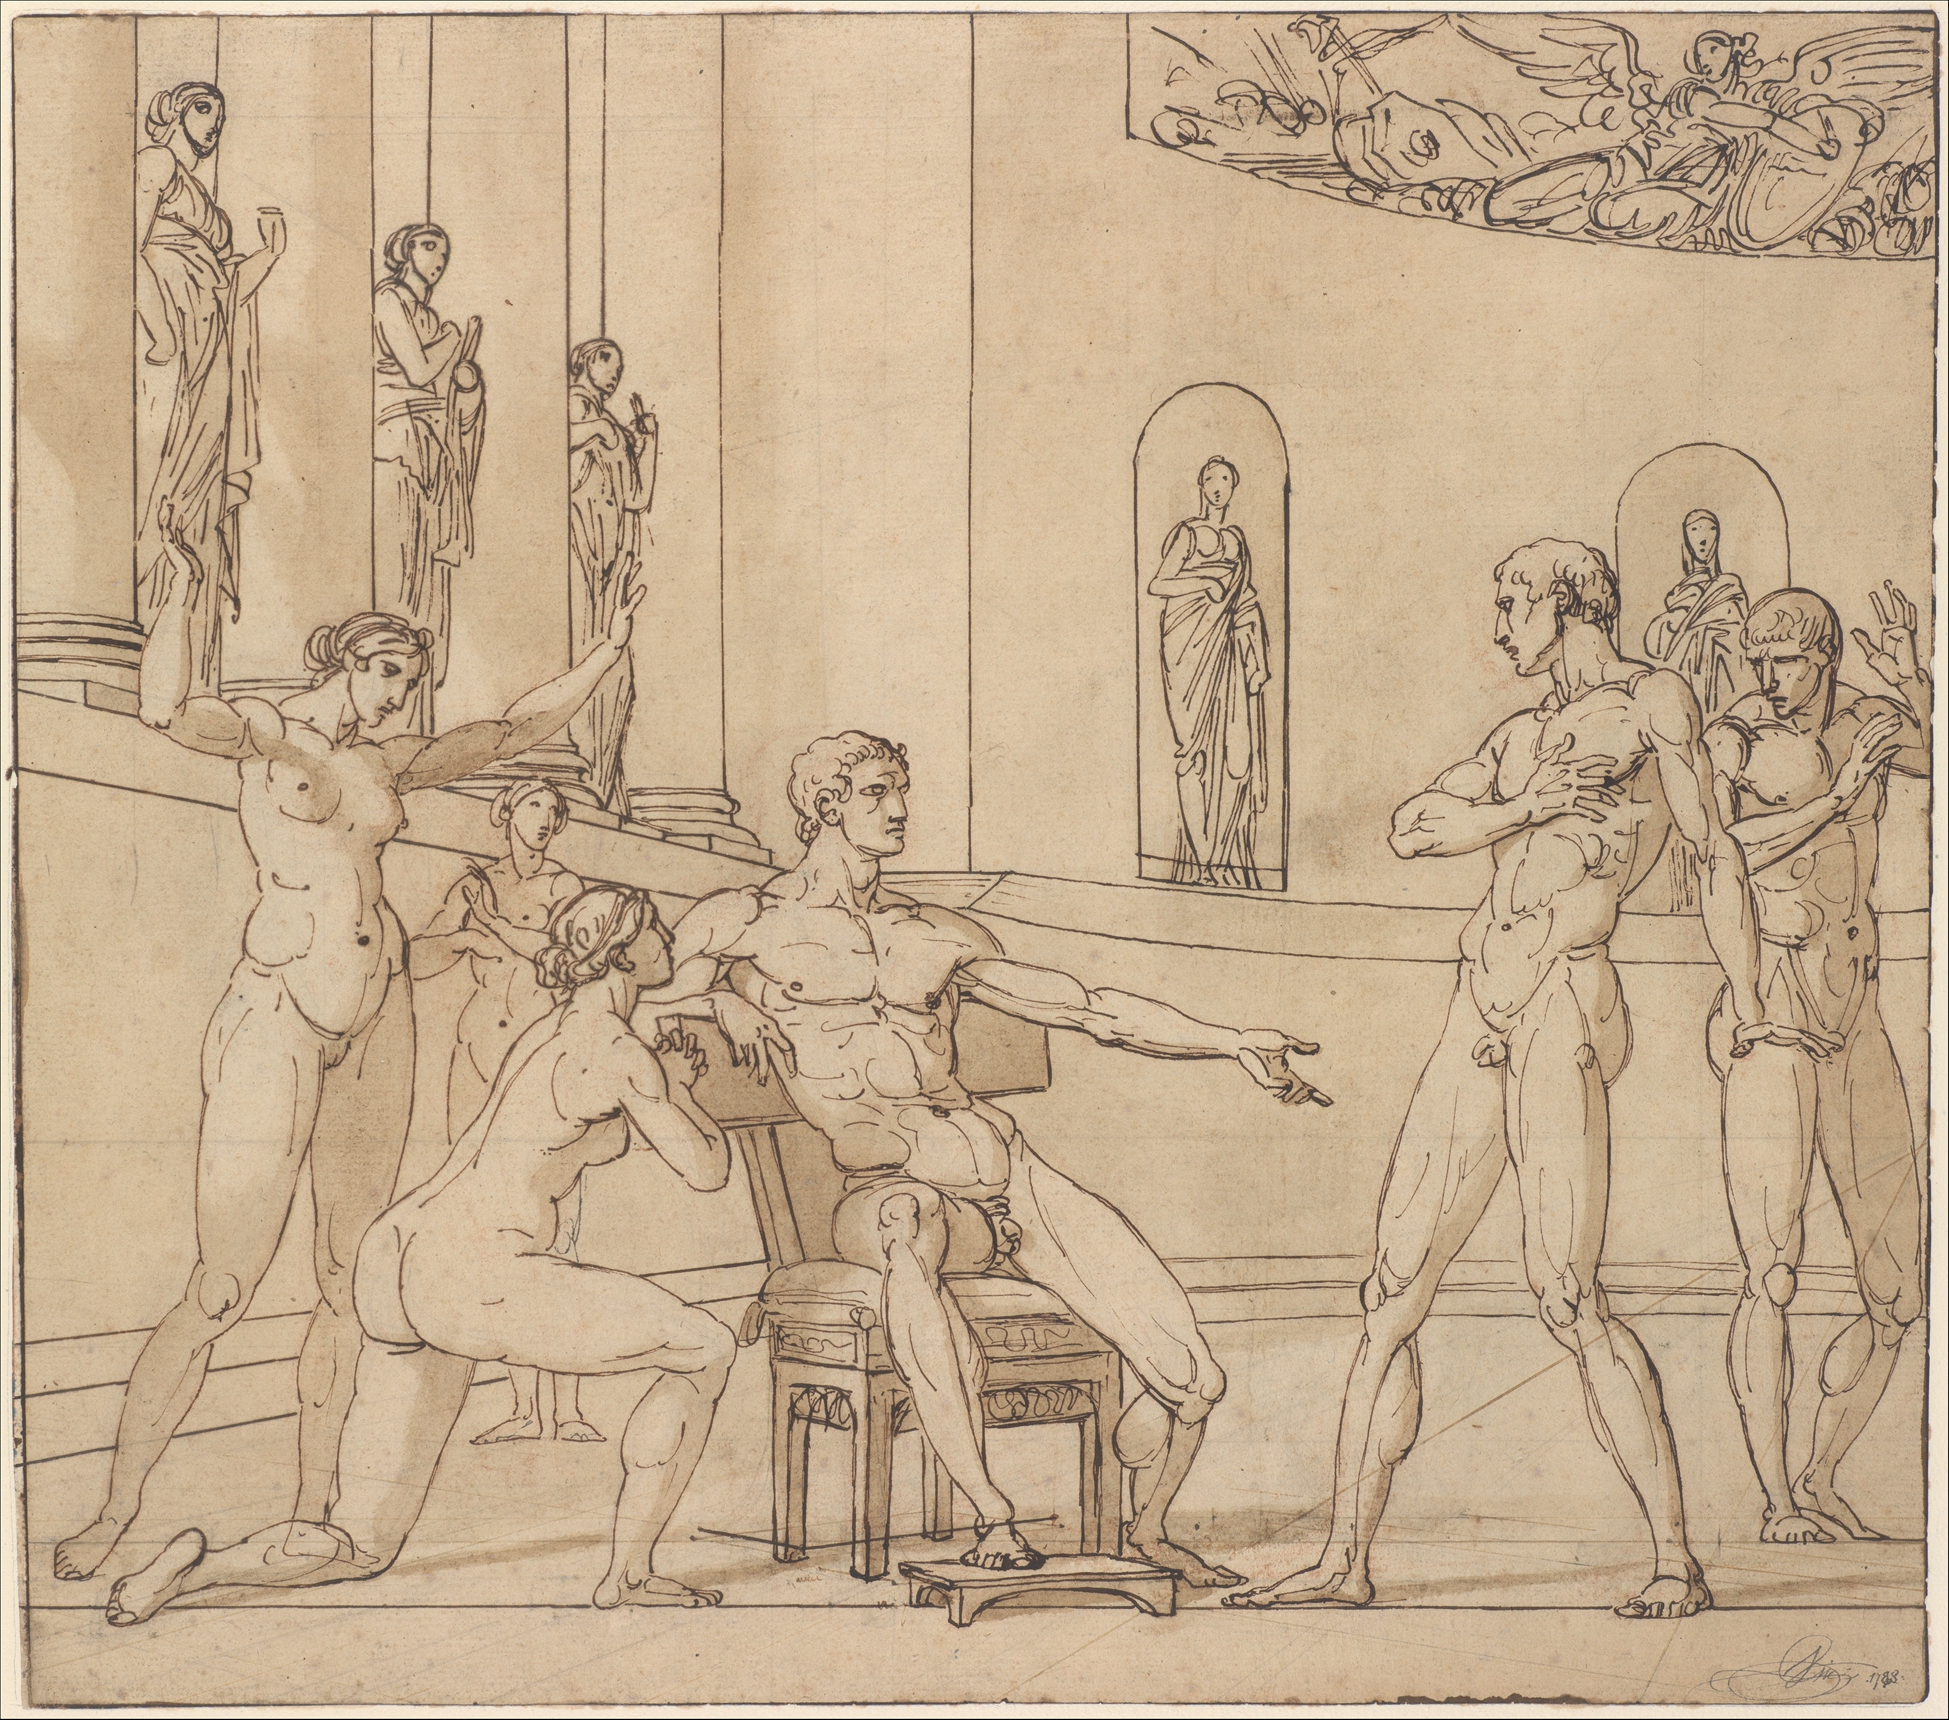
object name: drawing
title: The Clemency of Augustus (recto); Knight Restraining a Female Figure (verso)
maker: françois andré vincent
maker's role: artist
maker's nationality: french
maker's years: 1746-1816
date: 1787-1788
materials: chalk, graphite, ink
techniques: brush, pen, drawing, wash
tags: emperor augustus,male nudes,female nudes